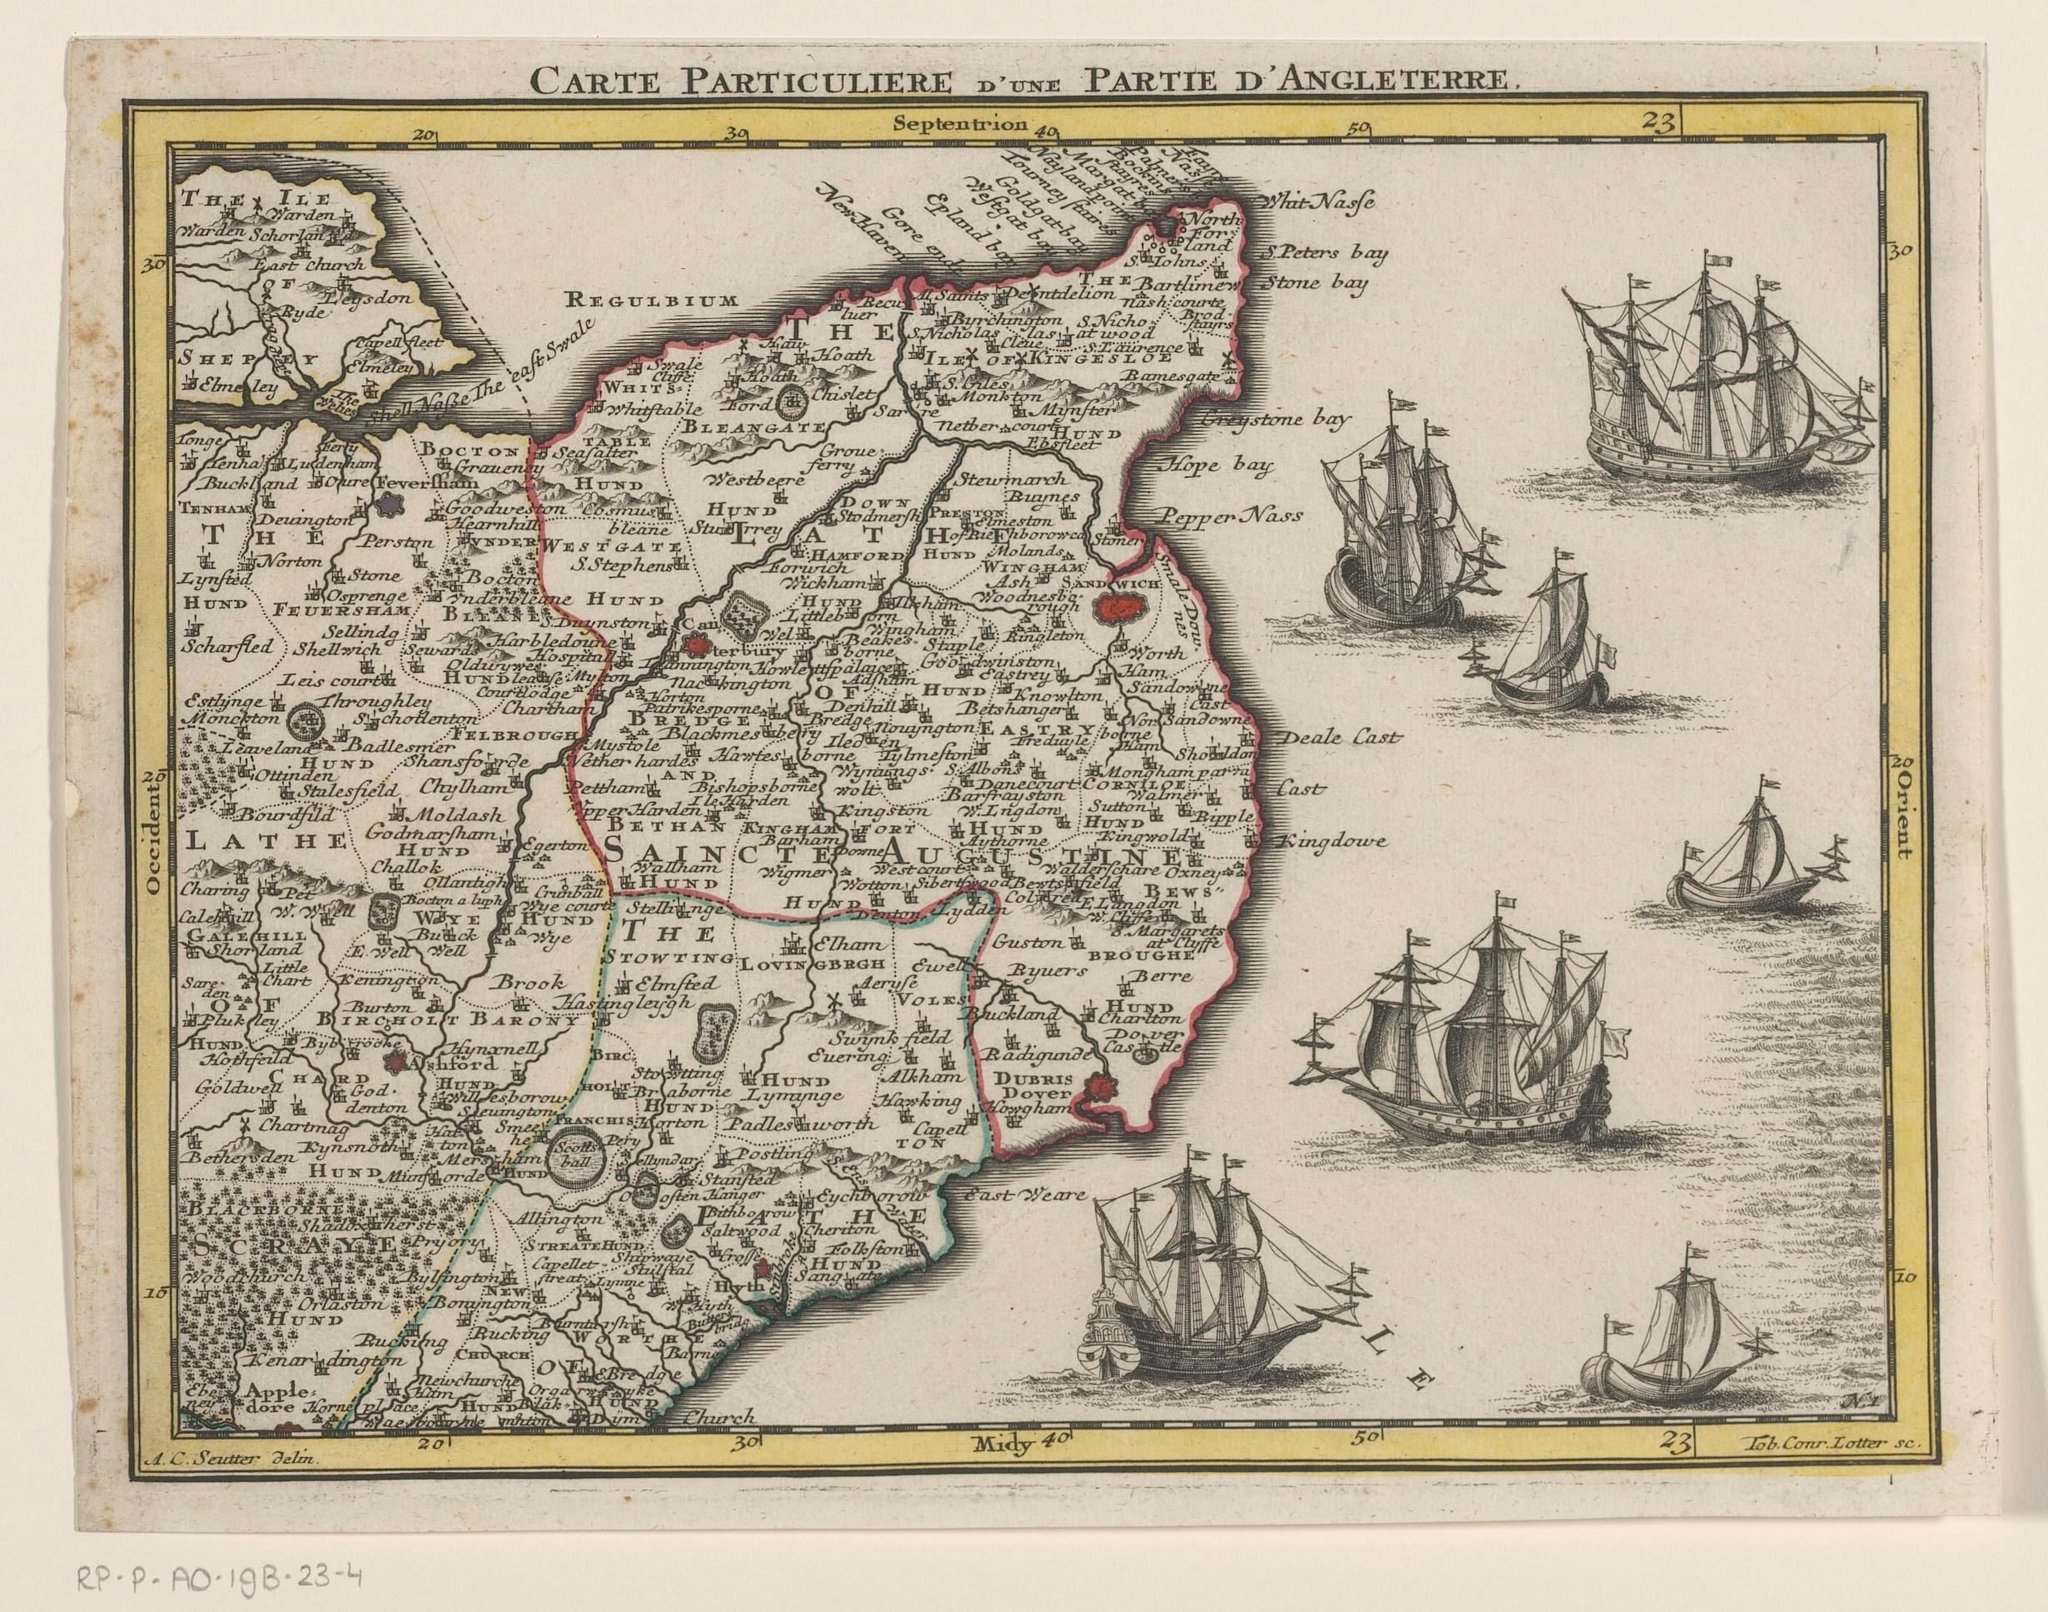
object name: print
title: Deel van een kaart van de Oostenrijkse Nederlanden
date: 1737-1757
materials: paper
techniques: engraving, etching, hand coloring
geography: augsburg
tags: maps of separate countries or regions, southern netherlands, belgium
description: Deze kaart is onderdeel van een wandkaart van de Oostenrijkse Nederlanden, bestaande uit vier rijen van zes delen. De delen van de kaart zijn rechtsonder genummerd, beginnend bij het deel linksboven (1) tot het deel rechtsonder (24).